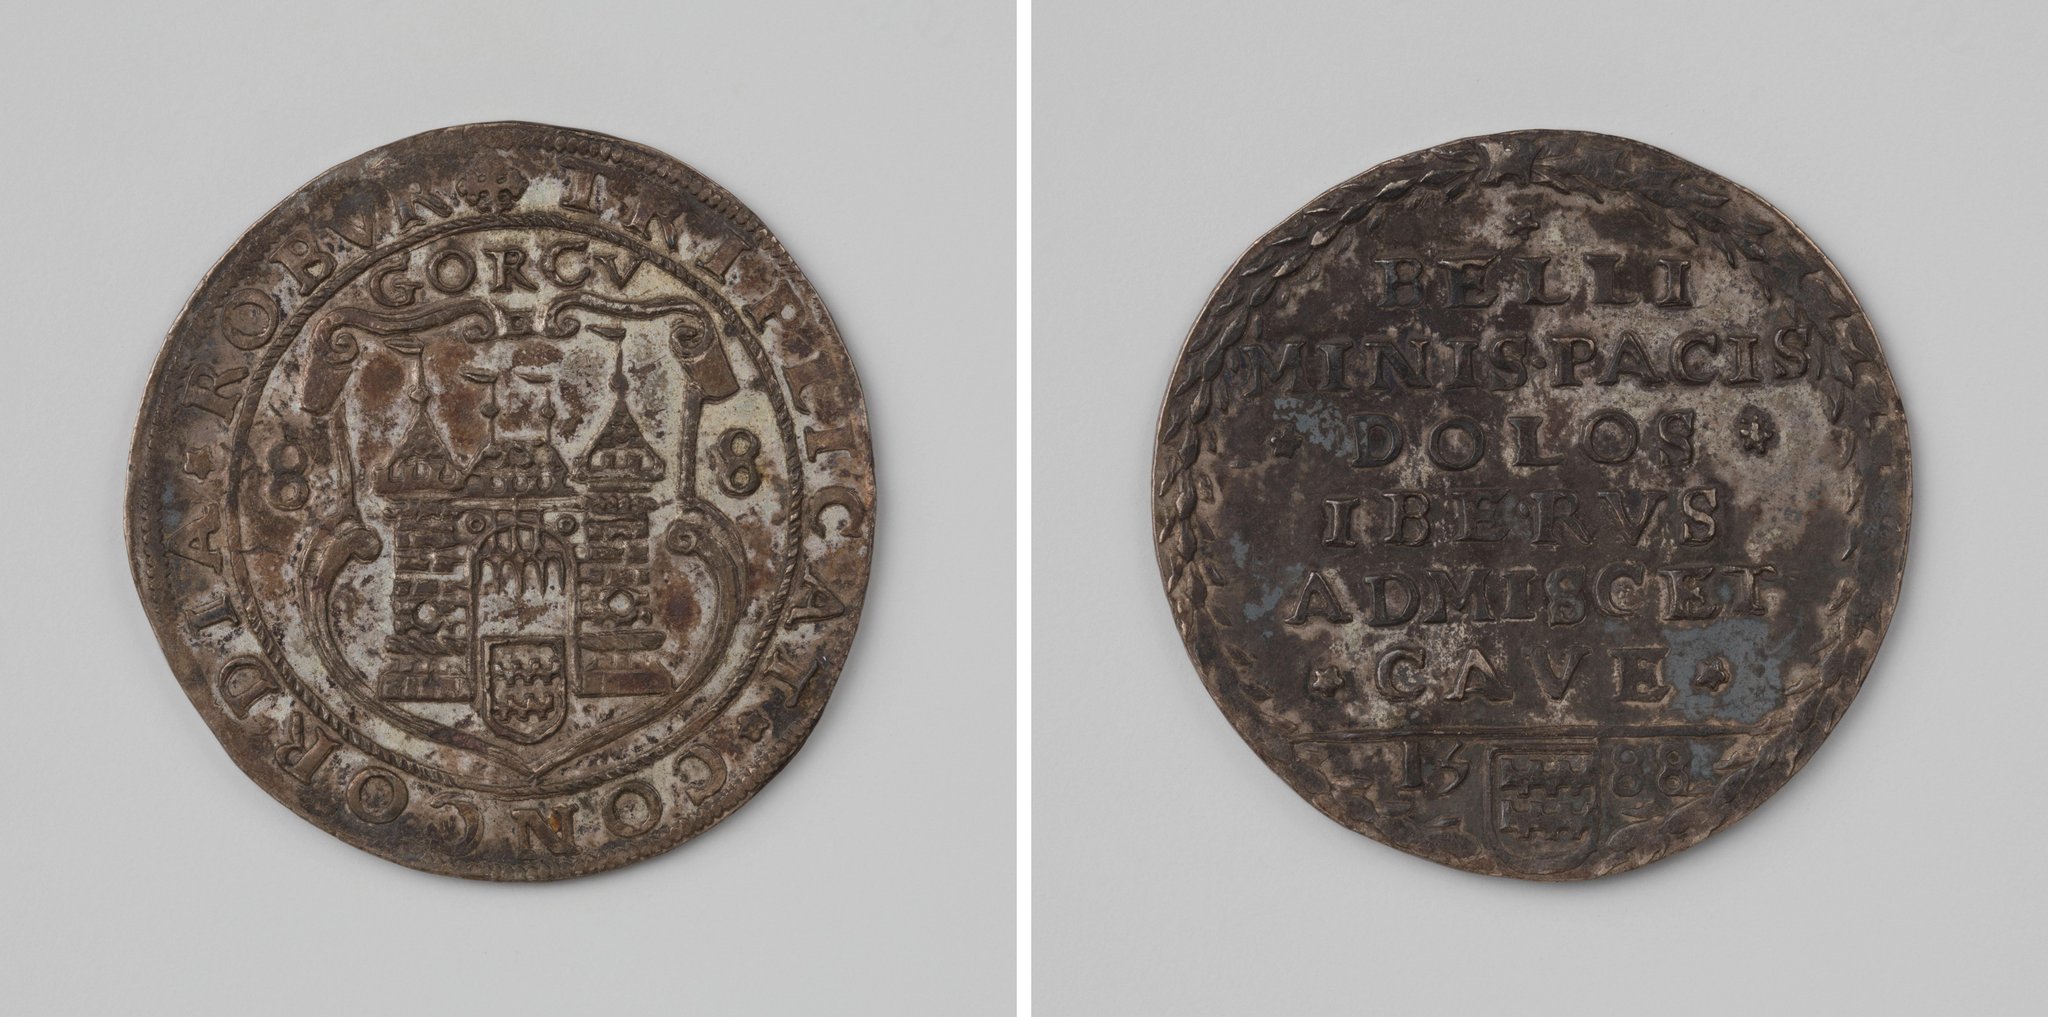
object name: jeton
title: Waarschuwing tegen de onderhandelingen te Broekburg met Spanje, rekenpenning van de stad Gorinchem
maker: Anonymous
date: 1588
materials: silver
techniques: striking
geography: netherlands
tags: bourbourg, gorinchem, onderhandelingen te broekburg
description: Zilveren penning. Voorzijde: wapenschild in cartouche tussen jaartal onder opschrift binnen omschrift. Keerzijde: opschrift binnen lauwerkrans; afsnede: wapenschild en jaartal